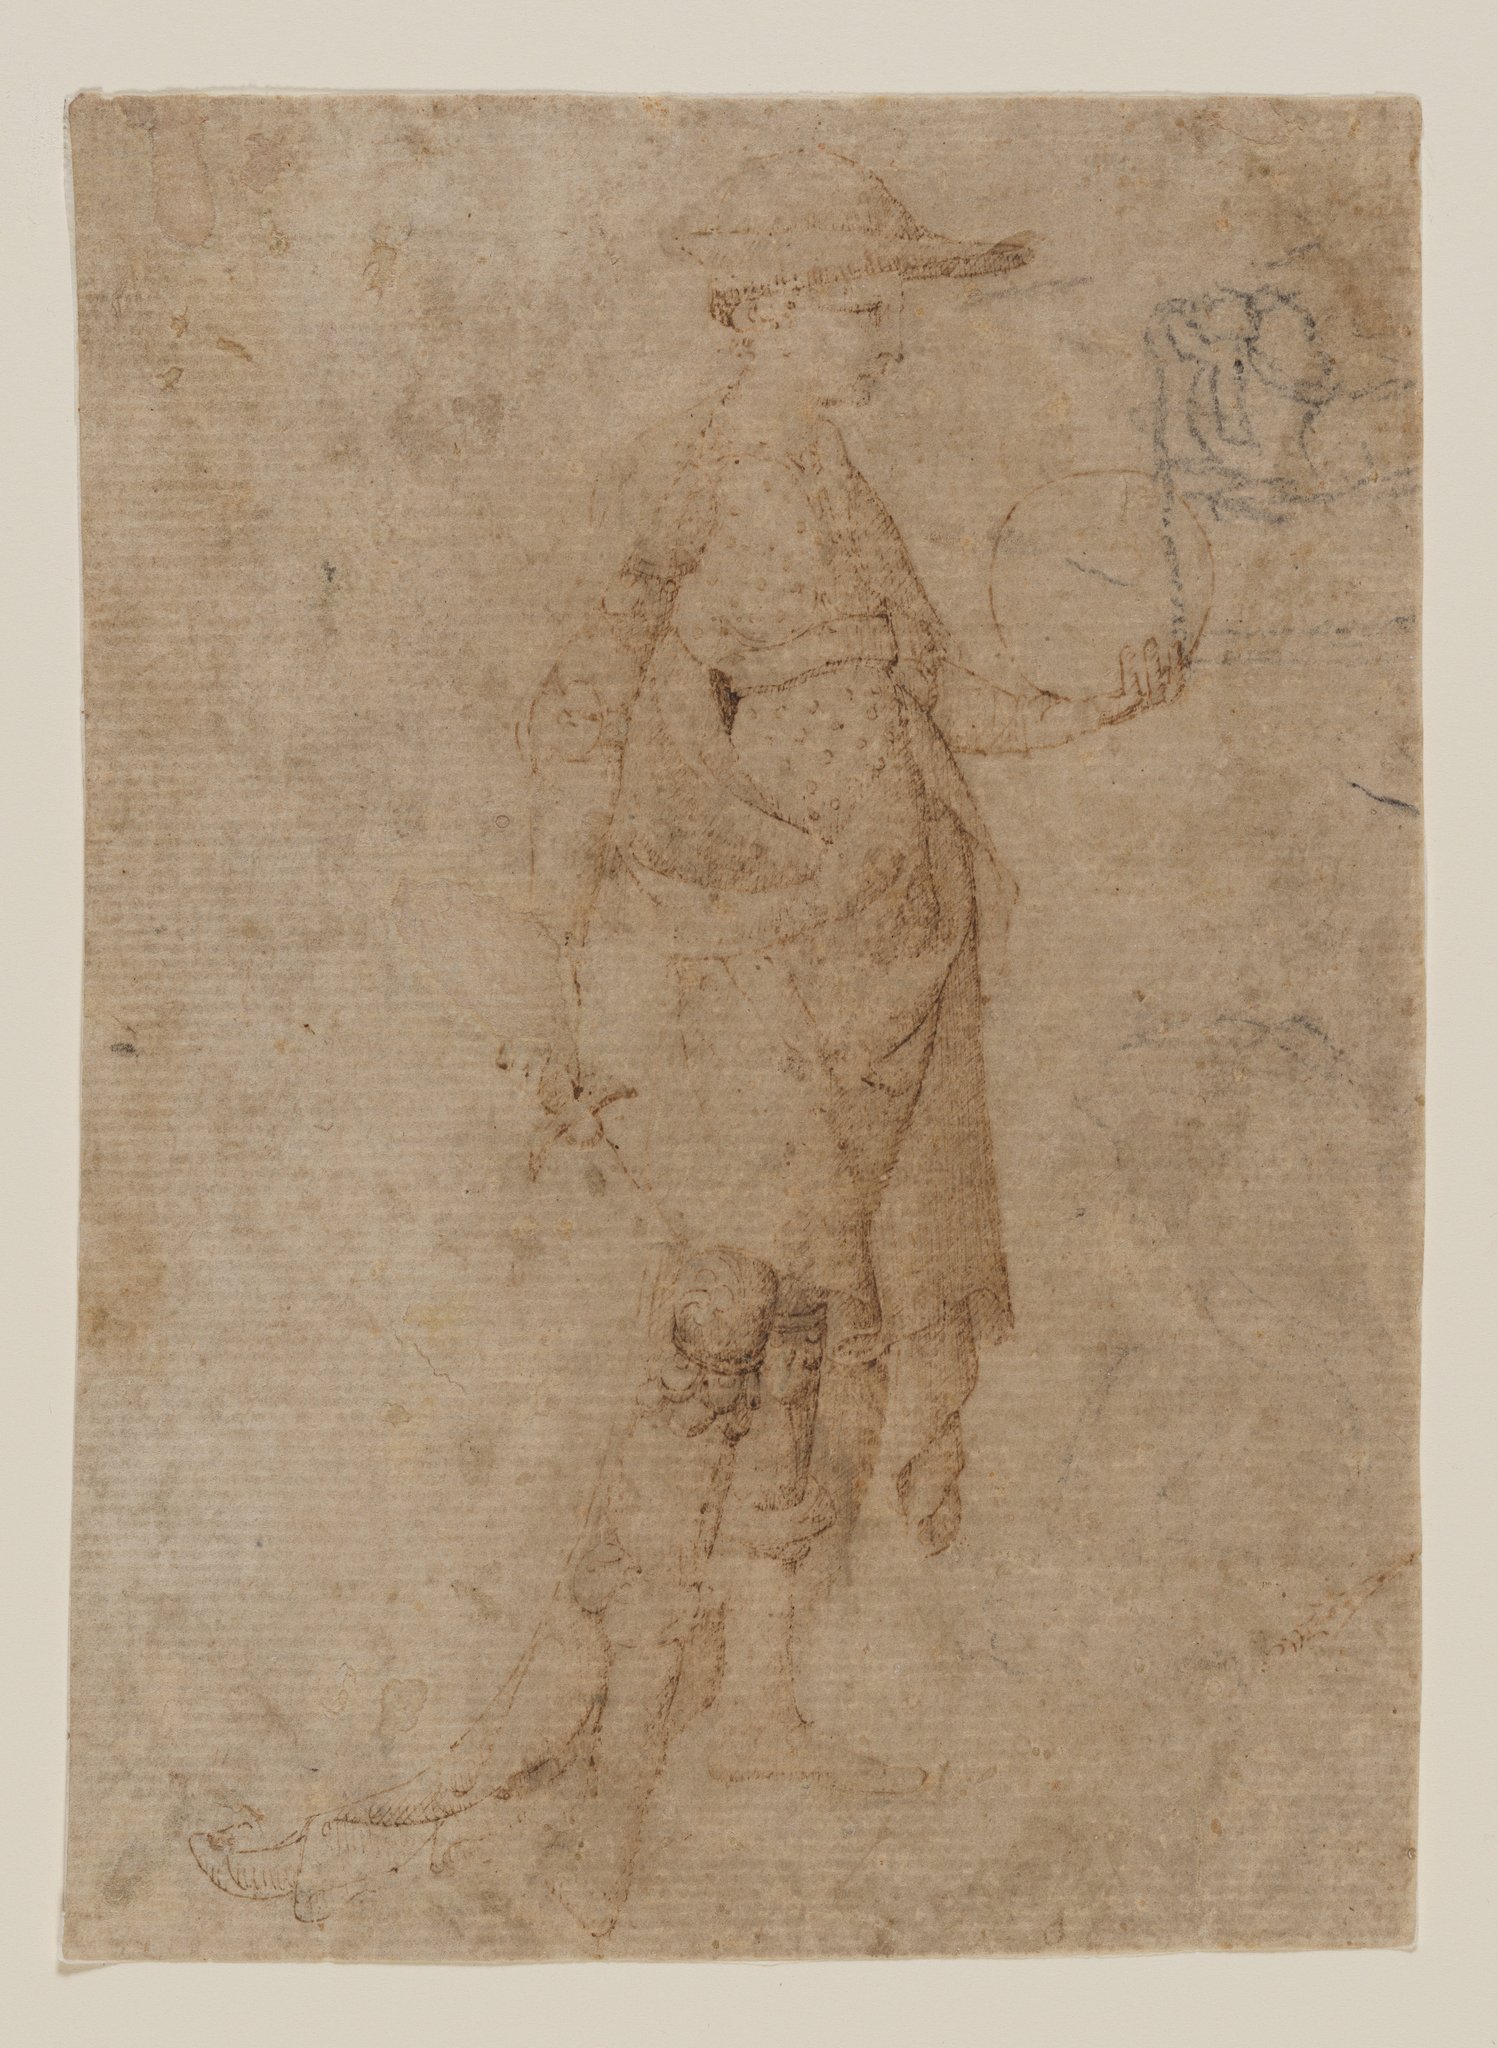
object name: drawing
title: A Young Man in Armor, Facing Right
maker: arcangelo di cola da camerino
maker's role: artist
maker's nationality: italian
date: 1425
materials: ink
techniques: pen, wash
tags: men